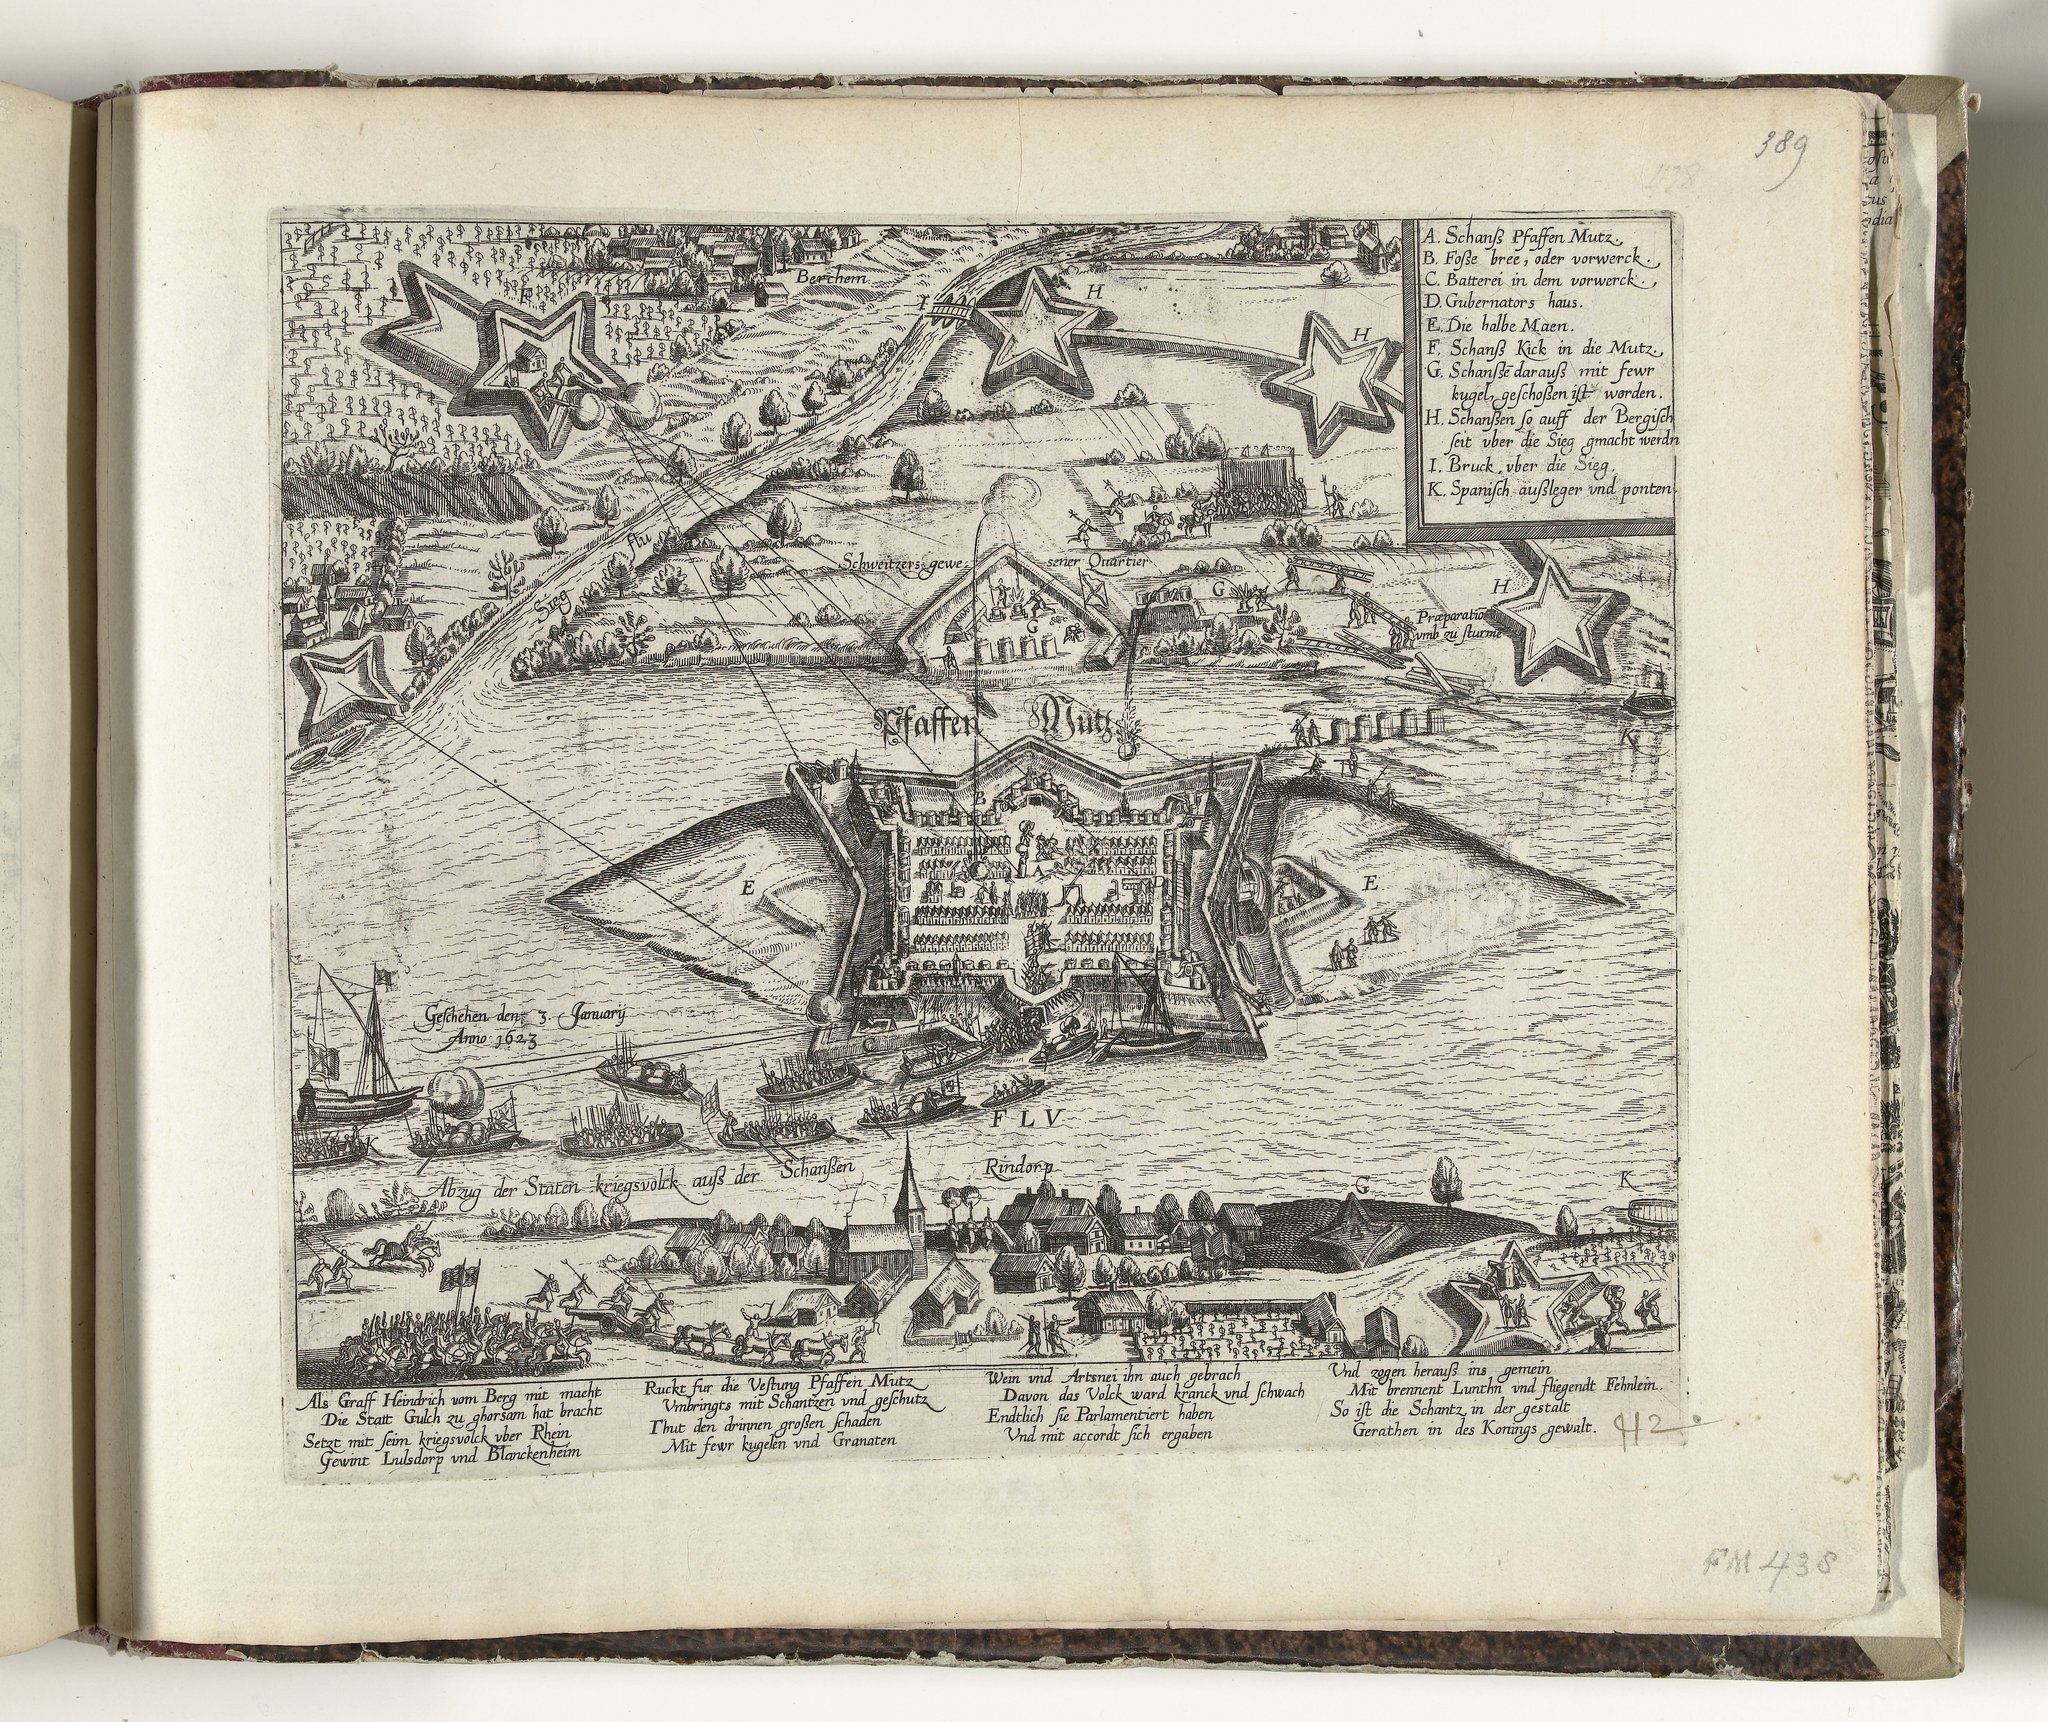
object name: print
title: Serie 11: Varia Buitenlandse Gebeurtenissen, 1571-1631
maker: frans hogenberg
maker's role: print maker, publisher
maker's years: 1538-1590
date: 1623-1625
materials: paper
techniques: etching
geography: cologne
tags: siege, position war, capture of city (after the siege)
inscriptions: inscription: ‘412’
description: Beleg en verovering van de schans Papenmuts (Pfaffenmutsz) in de Rijn tussen de dorpen Bergheim en Rheindorf door het Spaanse leger onder Hendrik van den Bergh, 3 januari 1623. Linksonder vertrekken de Staatse troepen in boten. Met onderschrift van 16 regels in het Duits, boven een legenda A-K. Rechtsonder met pen genummerd: 412. De prent maakt deel uit van een album.